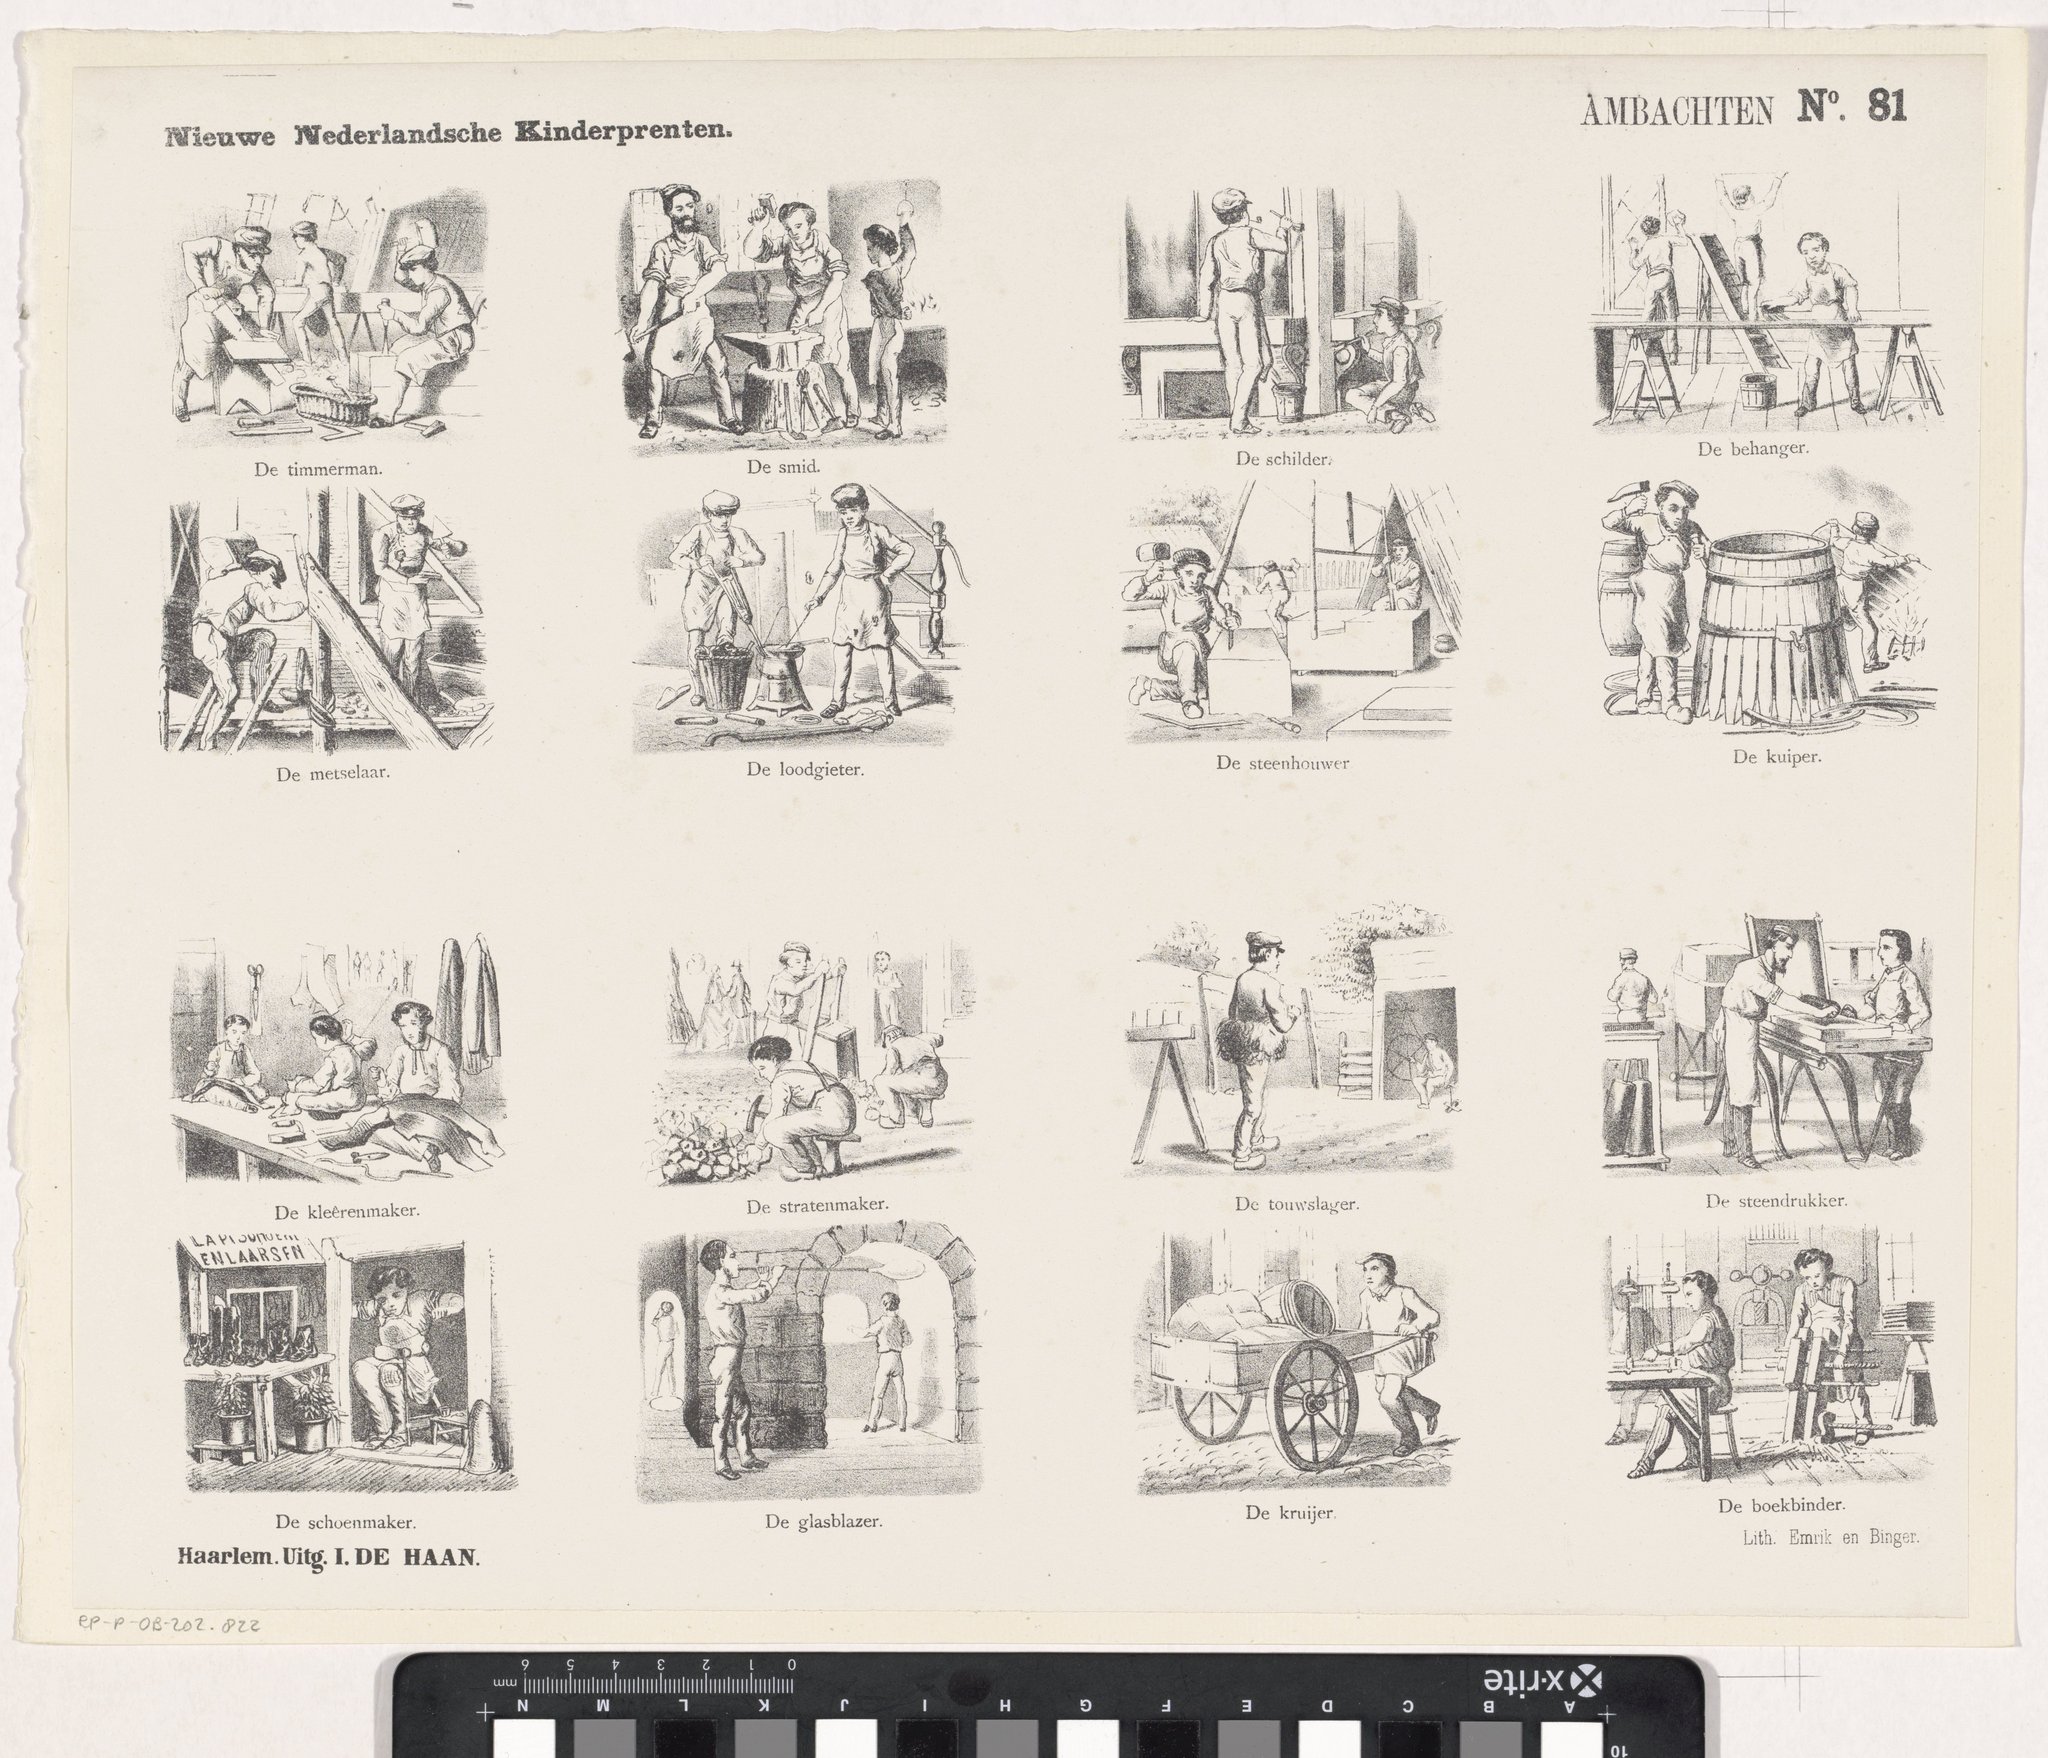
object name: popular print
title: Ambachten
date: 1875-1903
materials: paper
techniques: letterpress printing, lithograph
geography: haarlem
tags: carpenter, craft-production, skilled handiwork, smith, blacksmith, mason at work, crafts and industries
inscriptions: collector's mark: Lugt 2760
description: Blad met 16 voorstellingen van ambachtslieden en beroepen, zoals timmerman, smid, schilder en behanger. Onder elke voorstelling een onderschrift. Genummerd rechtsboven: No. 81.